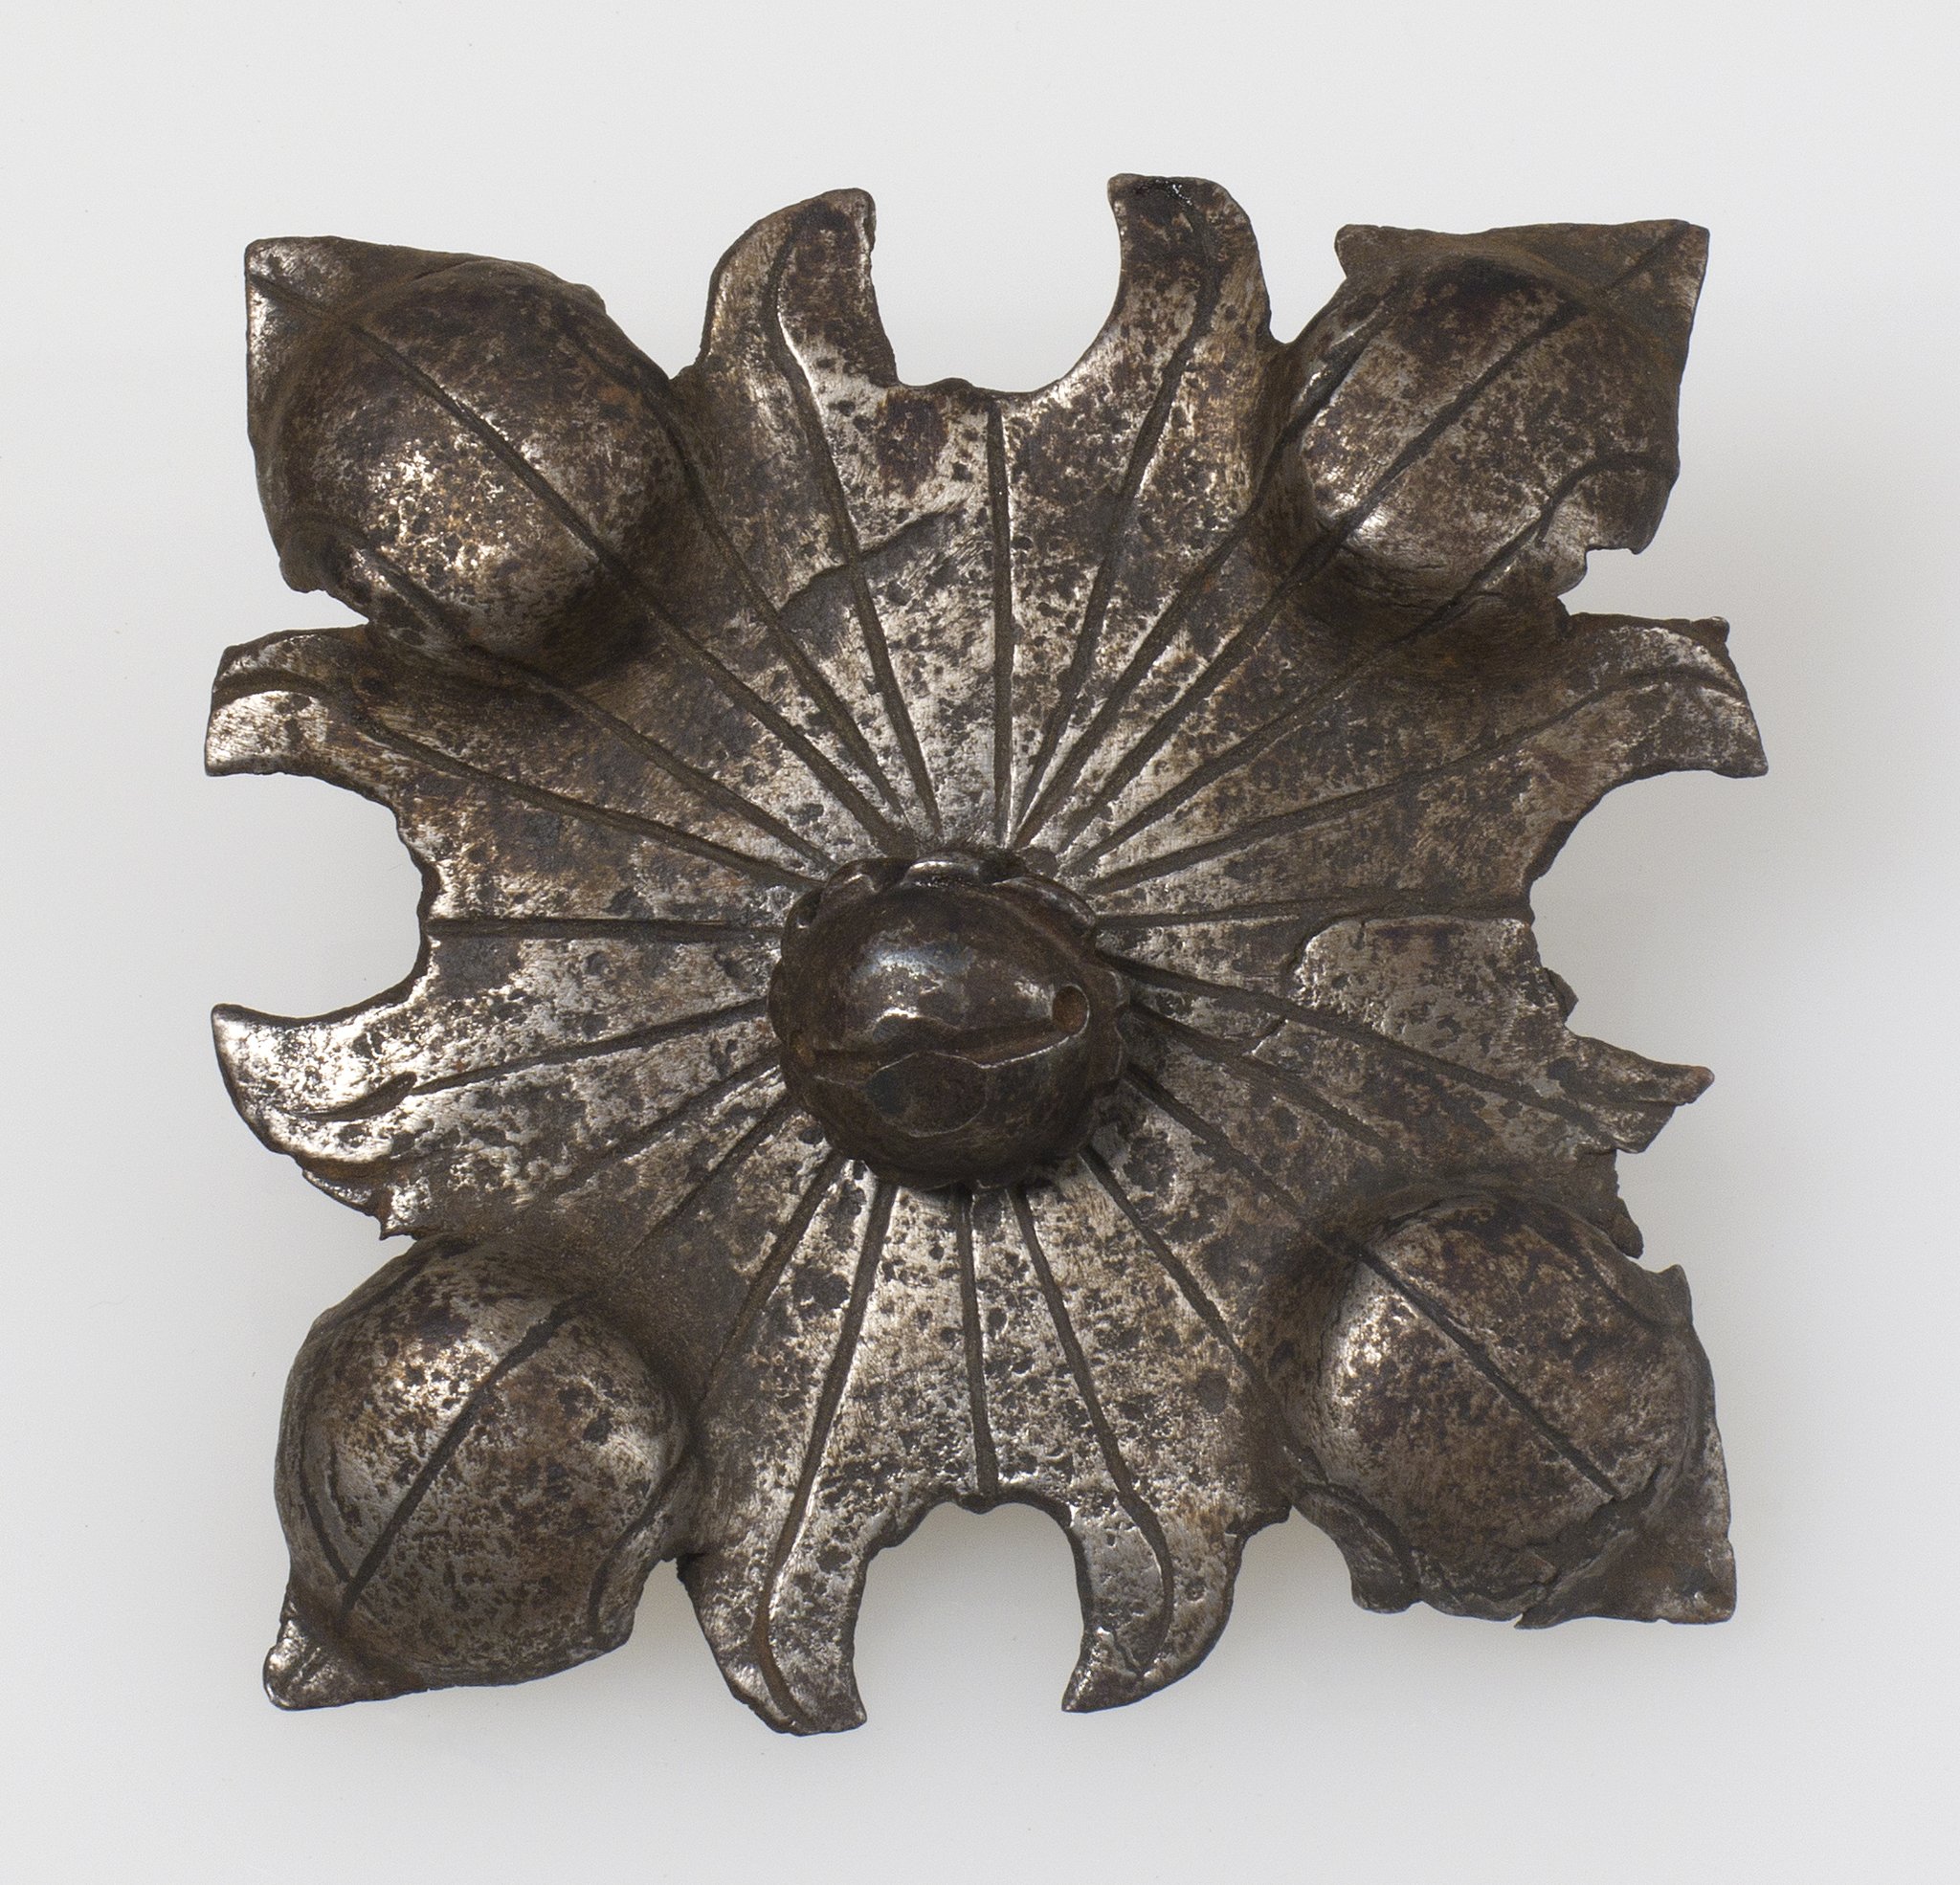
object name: plate and nail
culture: european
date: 1401-1600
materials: iron